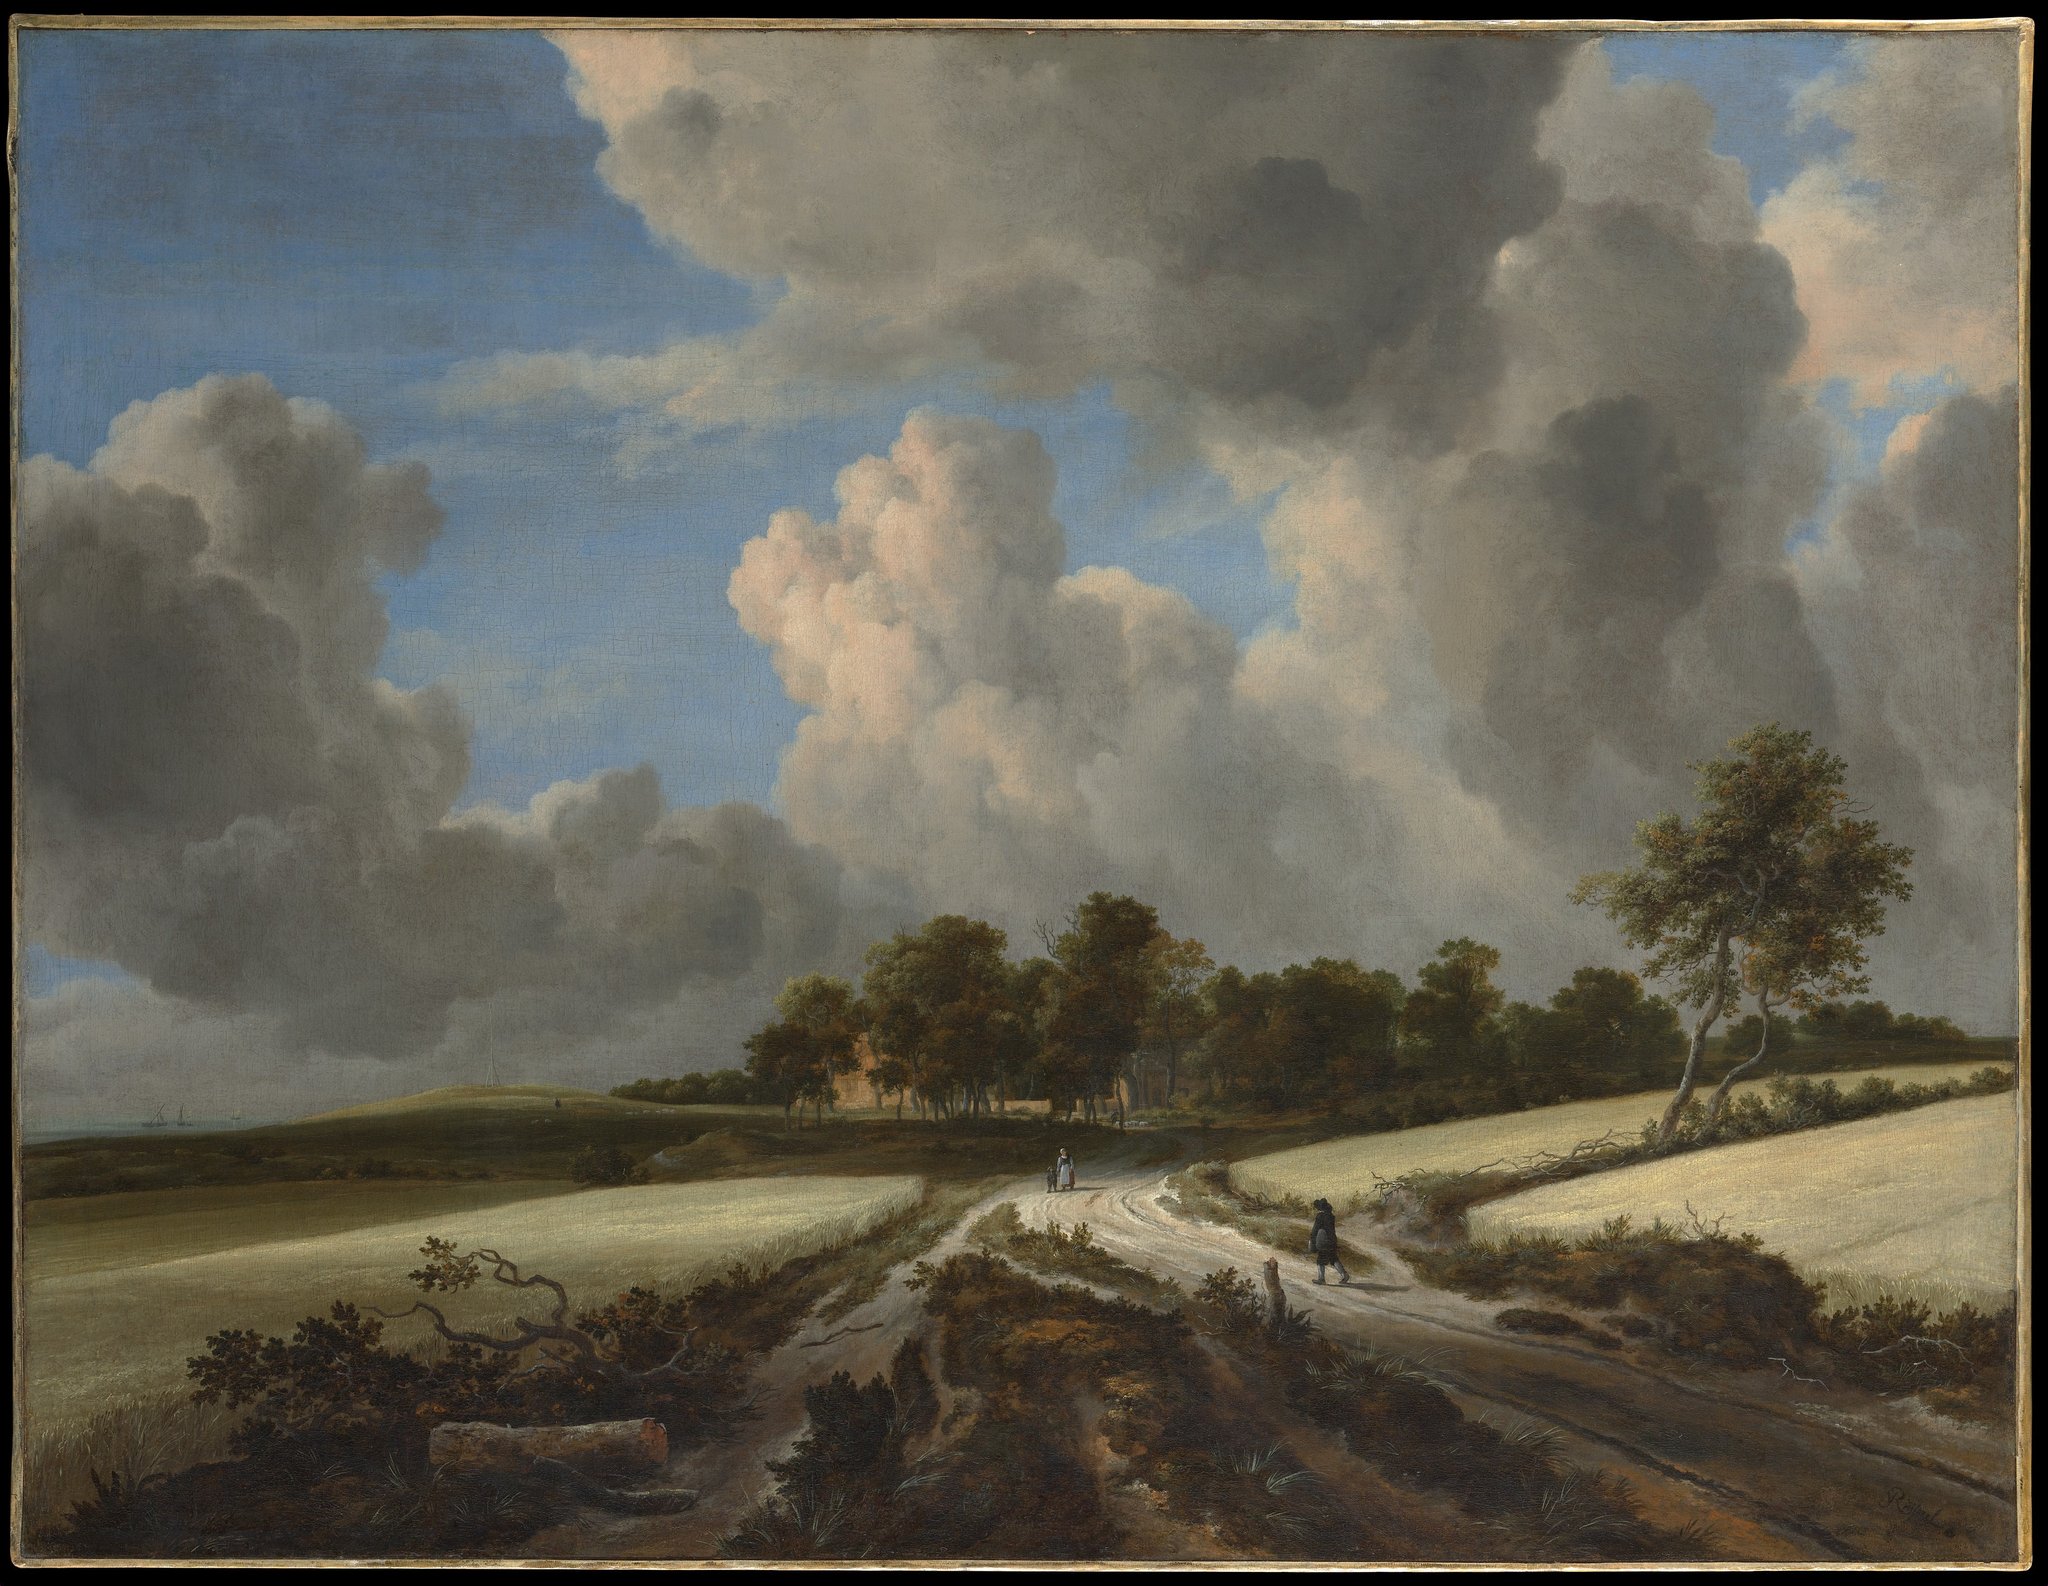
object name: painting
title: Wheat Fields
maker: jacob isaacksz van ruisdael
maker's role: artist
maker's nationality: dutch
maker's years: 1628-1682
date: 1670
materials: canvas, oil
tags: roads,landscapes